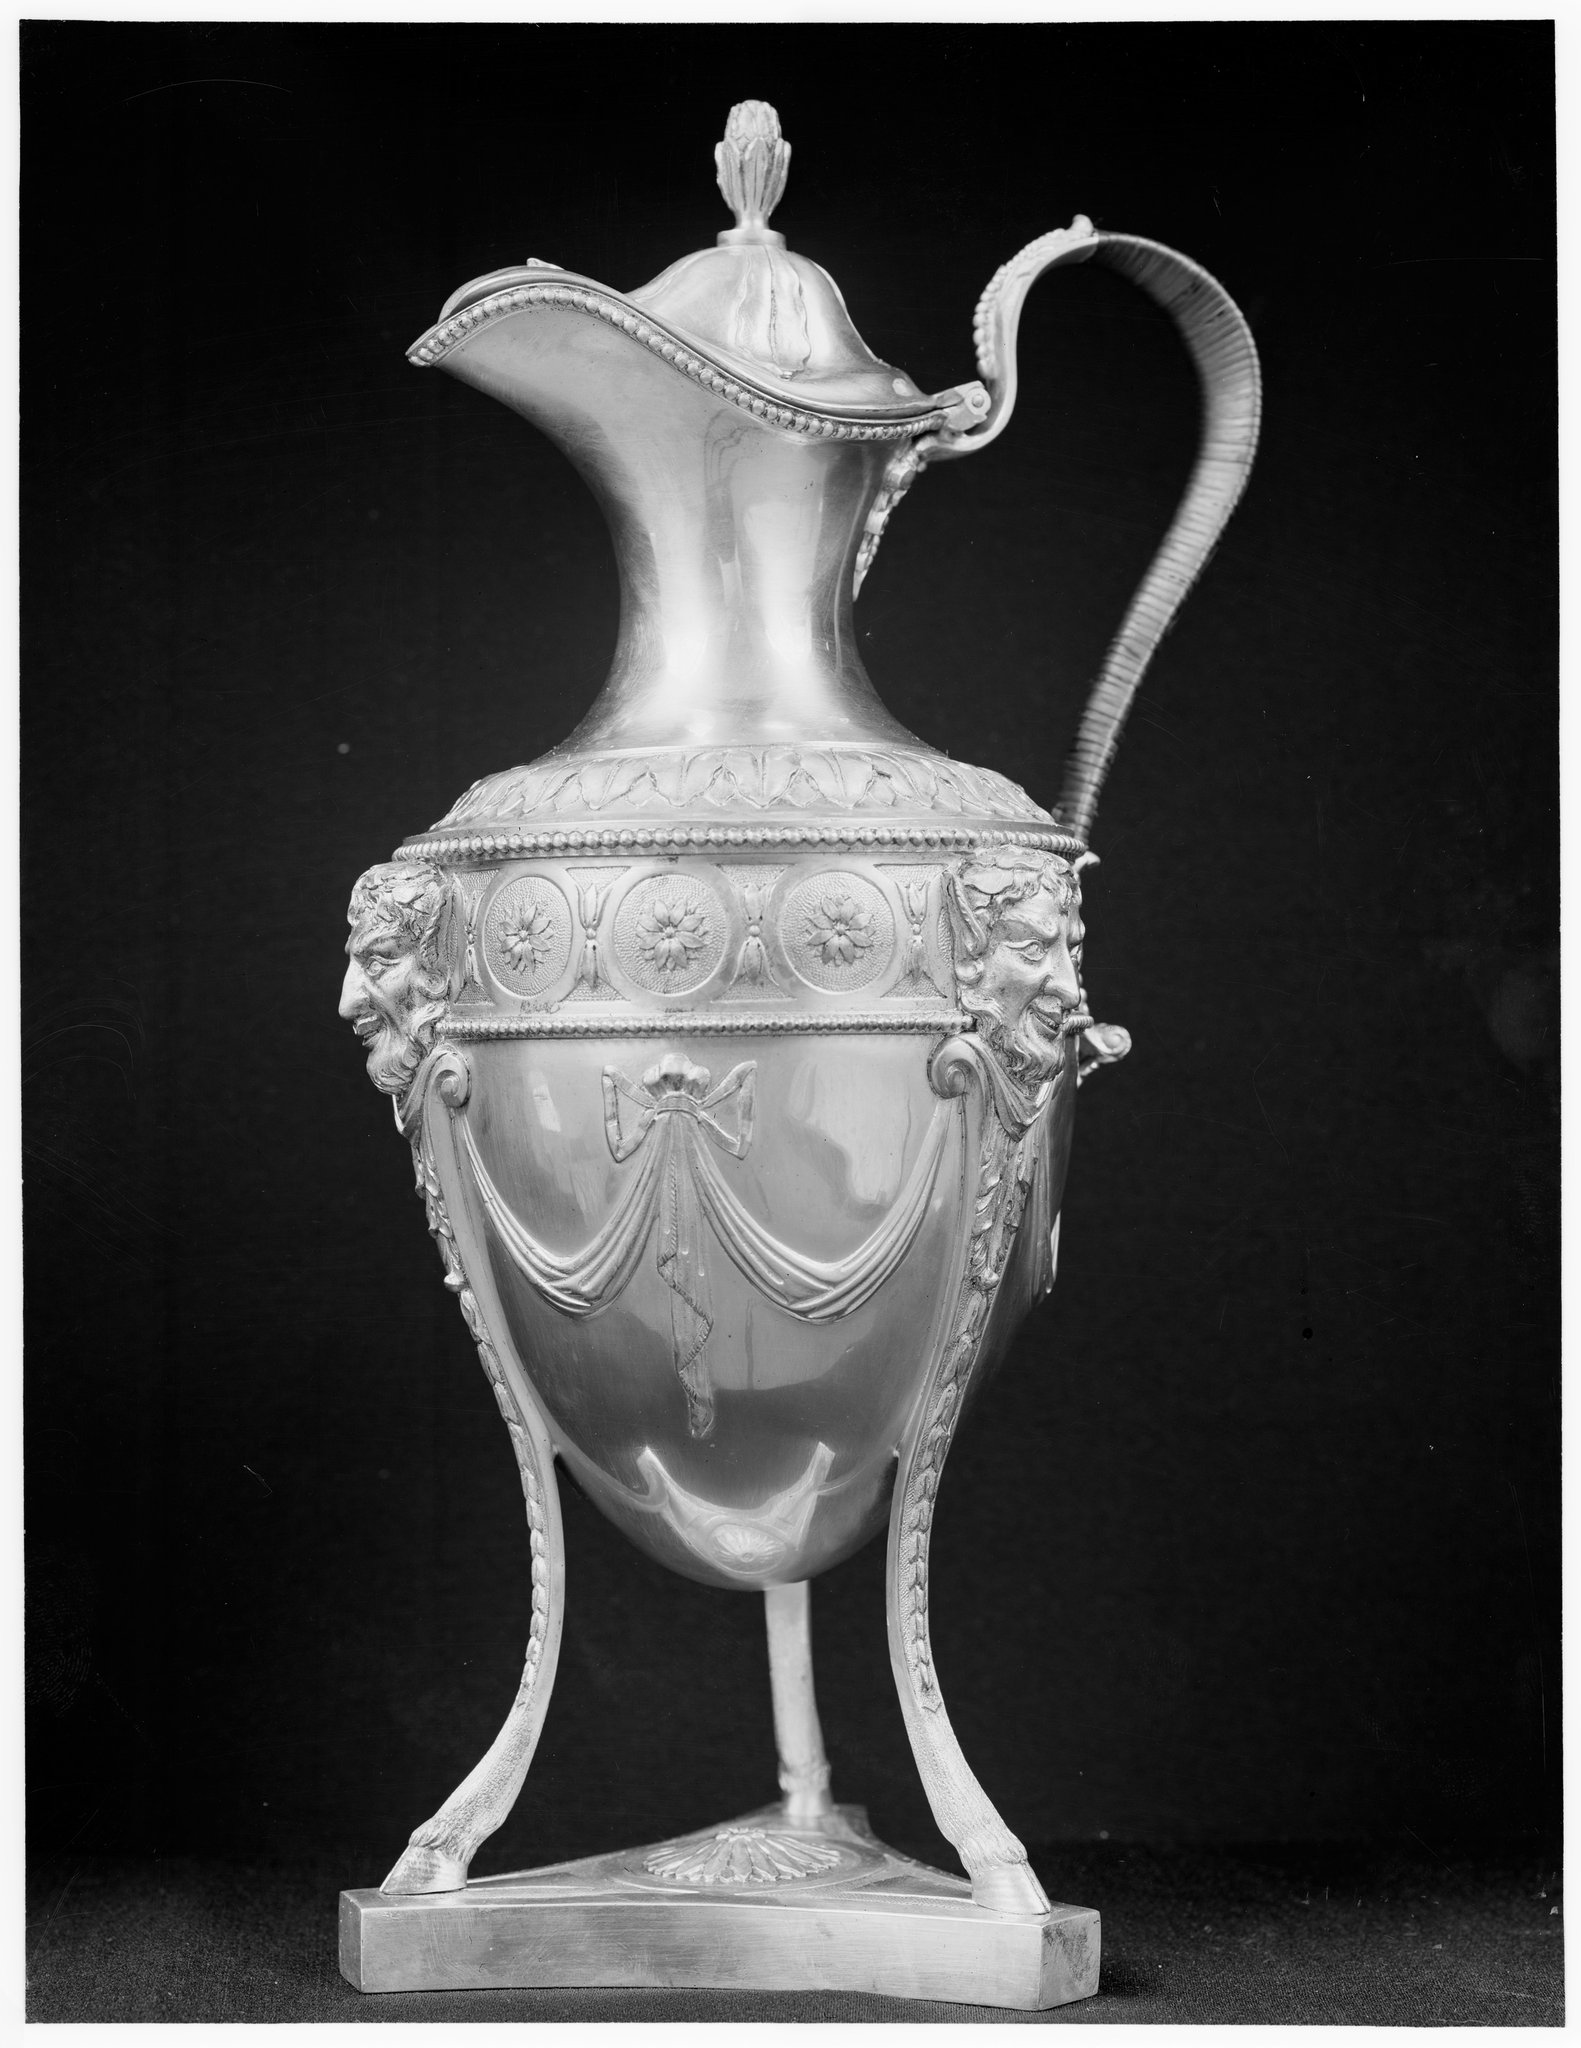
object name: chocolate pot with cover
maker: elkington & co.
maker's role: manufacturer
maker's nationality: british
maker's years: 1829-1963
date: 1801-1900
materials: metal, silver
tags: faces,flowers